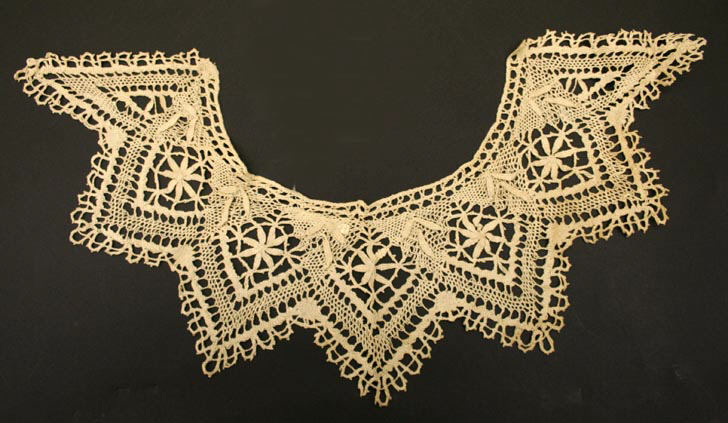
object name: collar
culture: american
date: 1700-1943